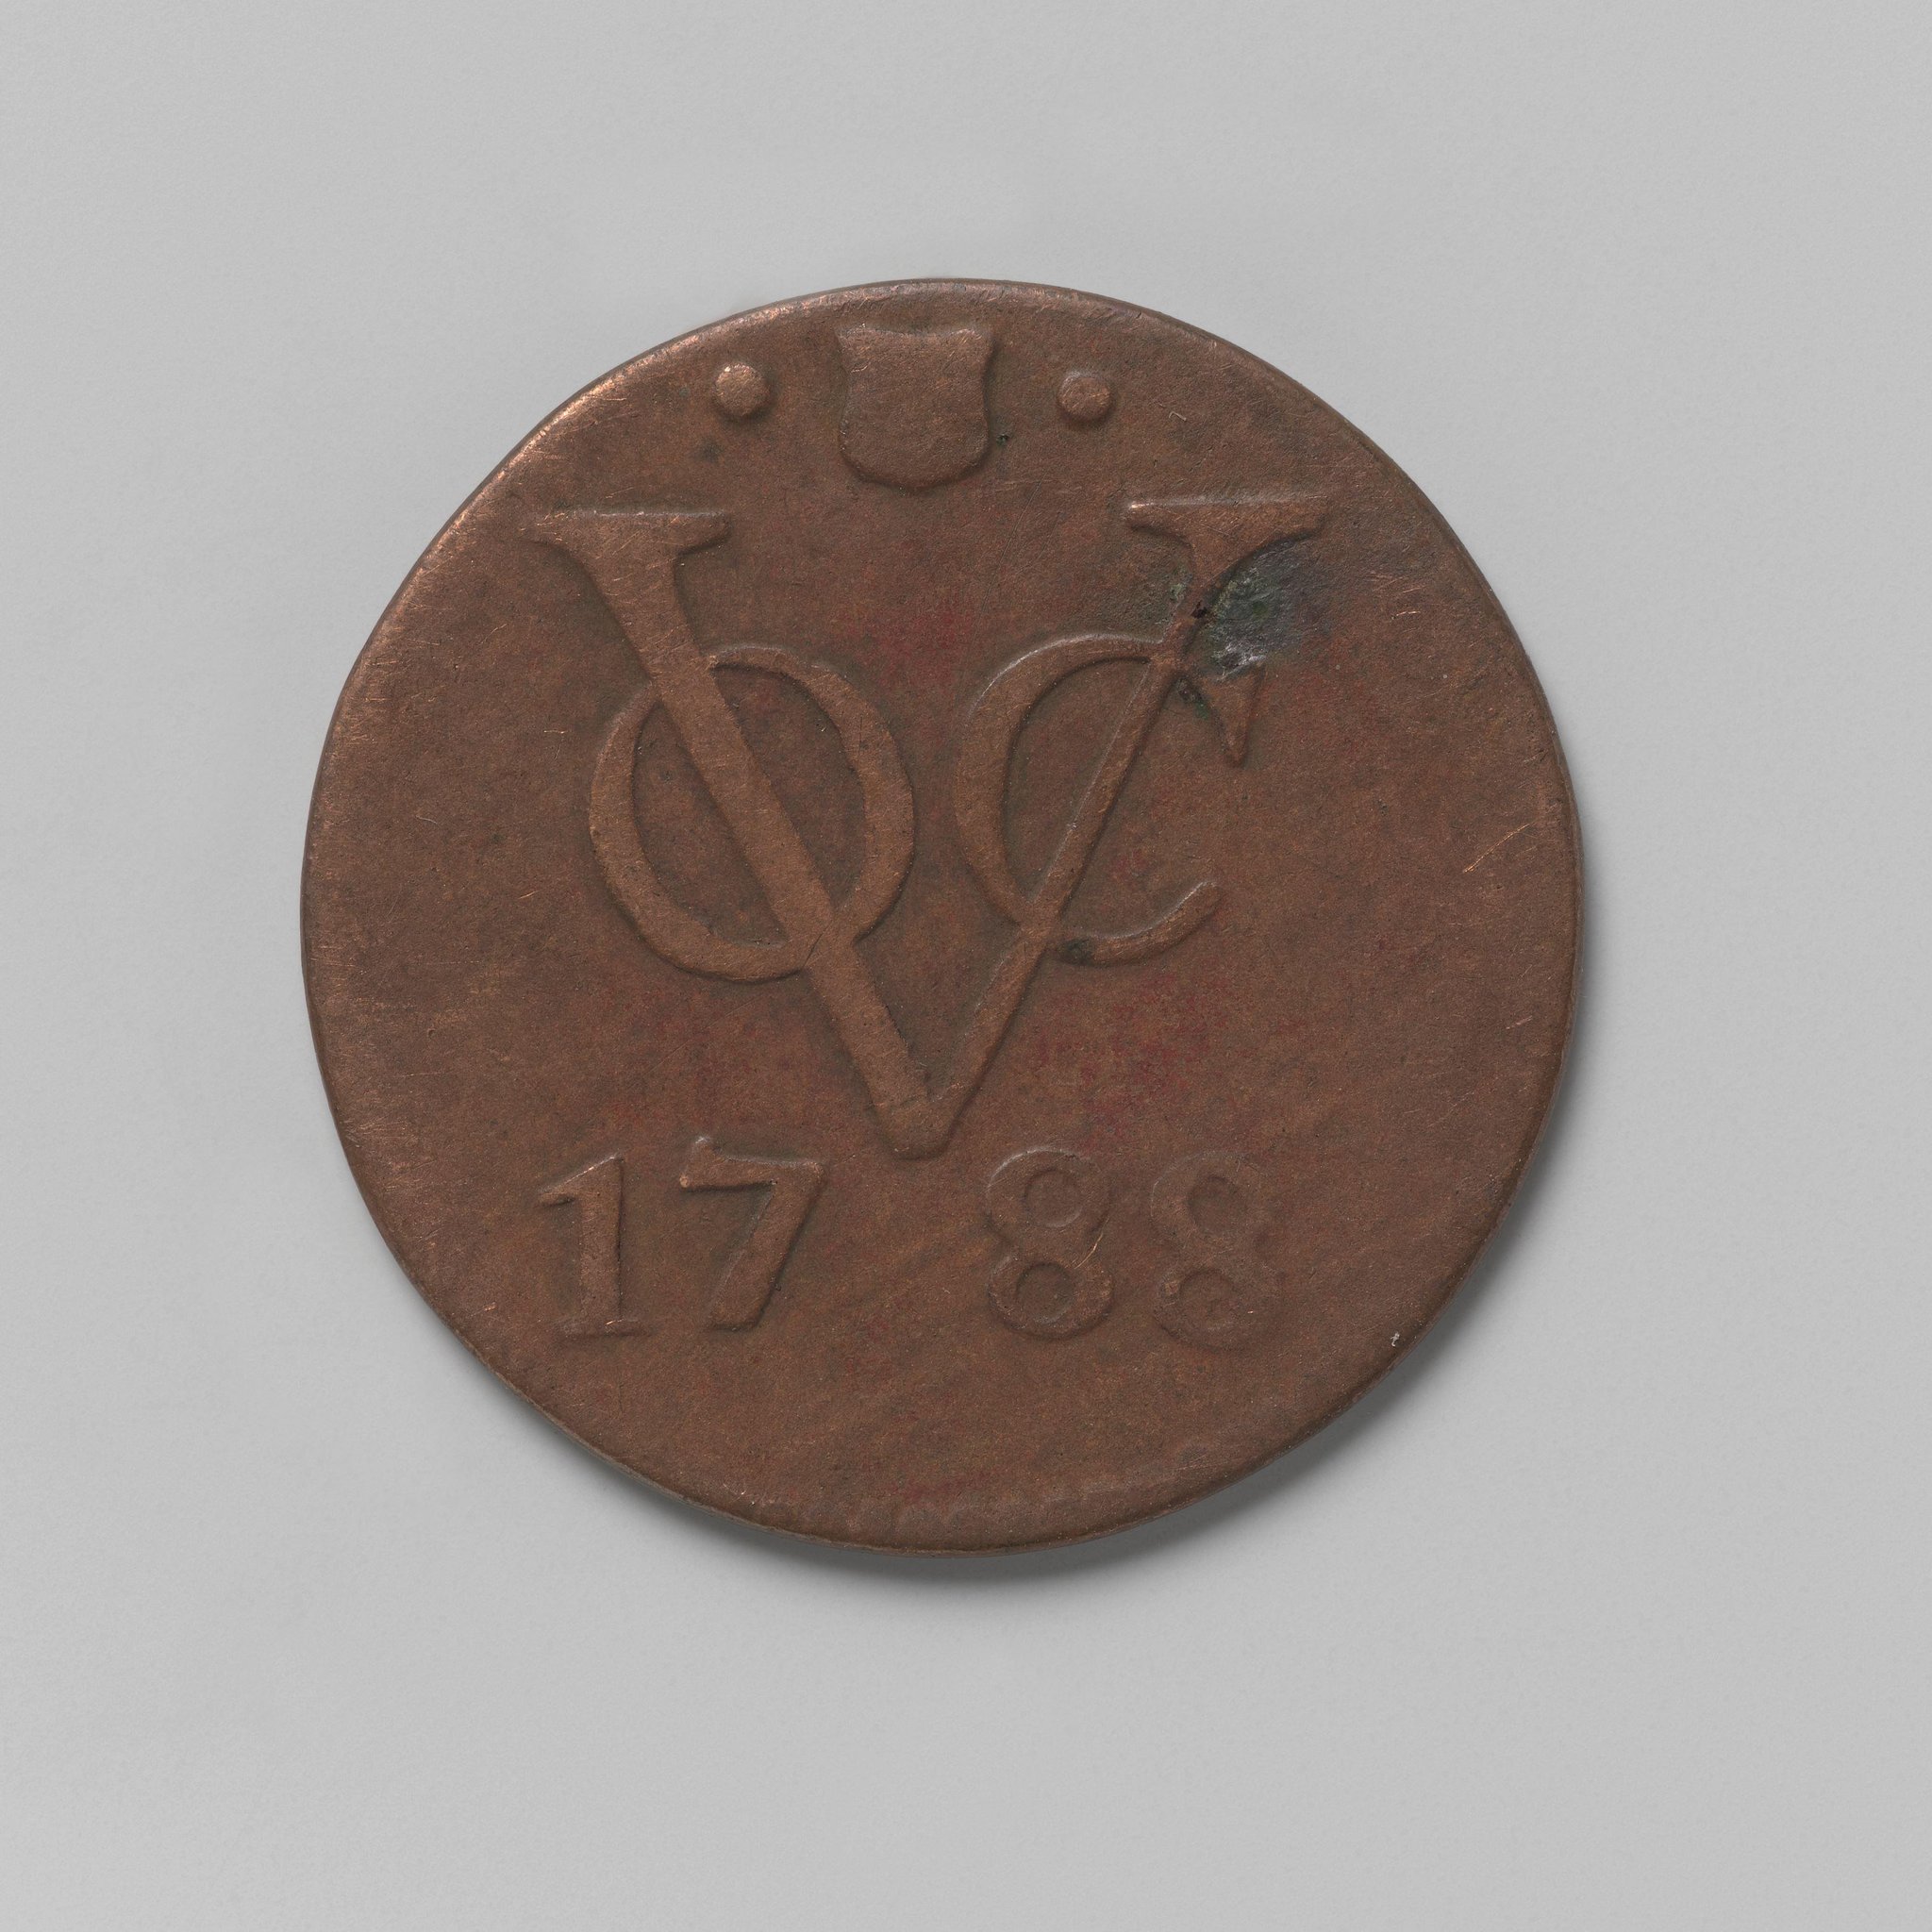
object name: coin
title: VOC, duit, stad Utrecht,1788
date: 1788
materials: copper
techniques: striking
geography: utrecht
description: Koperen munt. Voorzijde: op balk, waaronder guirlande, staand, door twee leeuwen gehouden gekroond wapenschild van de stad Utrecht. Keerzijde: monogram van de VOC, waarboven muntteken en waaronder jaartal. Gladde rand.